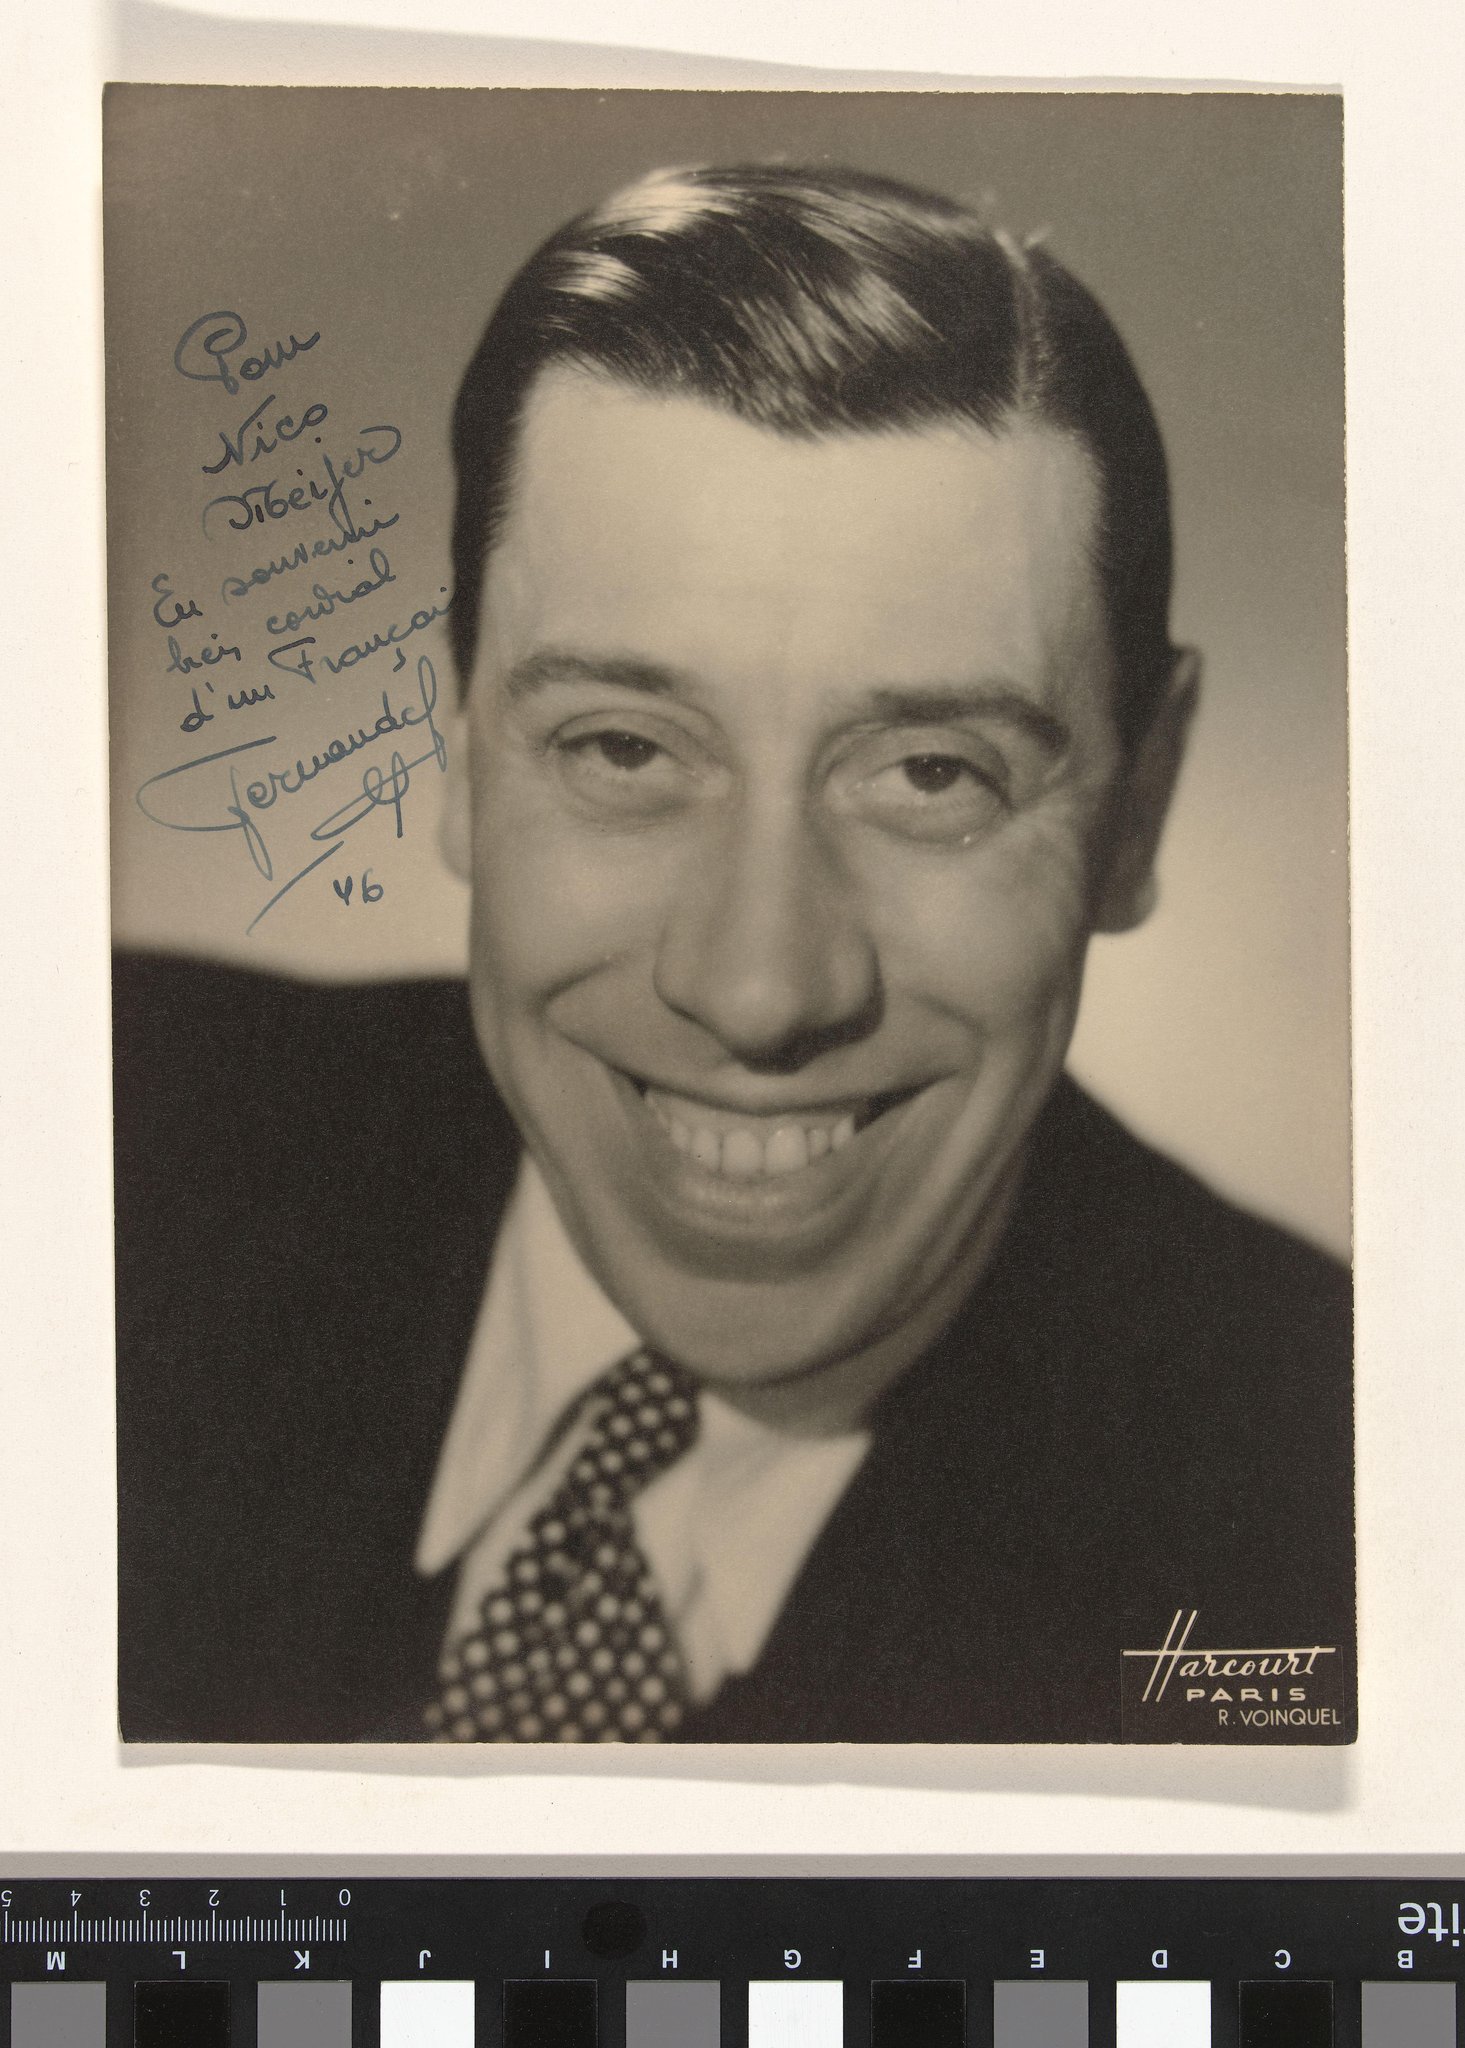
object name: photograph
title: Pour Nico Meijer, Un souvenir (...) d'un Français, Fernandel, 46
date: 1930-1950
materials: photographic support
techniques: gelatin silver print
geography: paris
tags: acteur, fernandel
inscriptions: inscription: ‘Fernand Contandin, ... van de Franse regering ontving hij "Het legioen van Eer"’